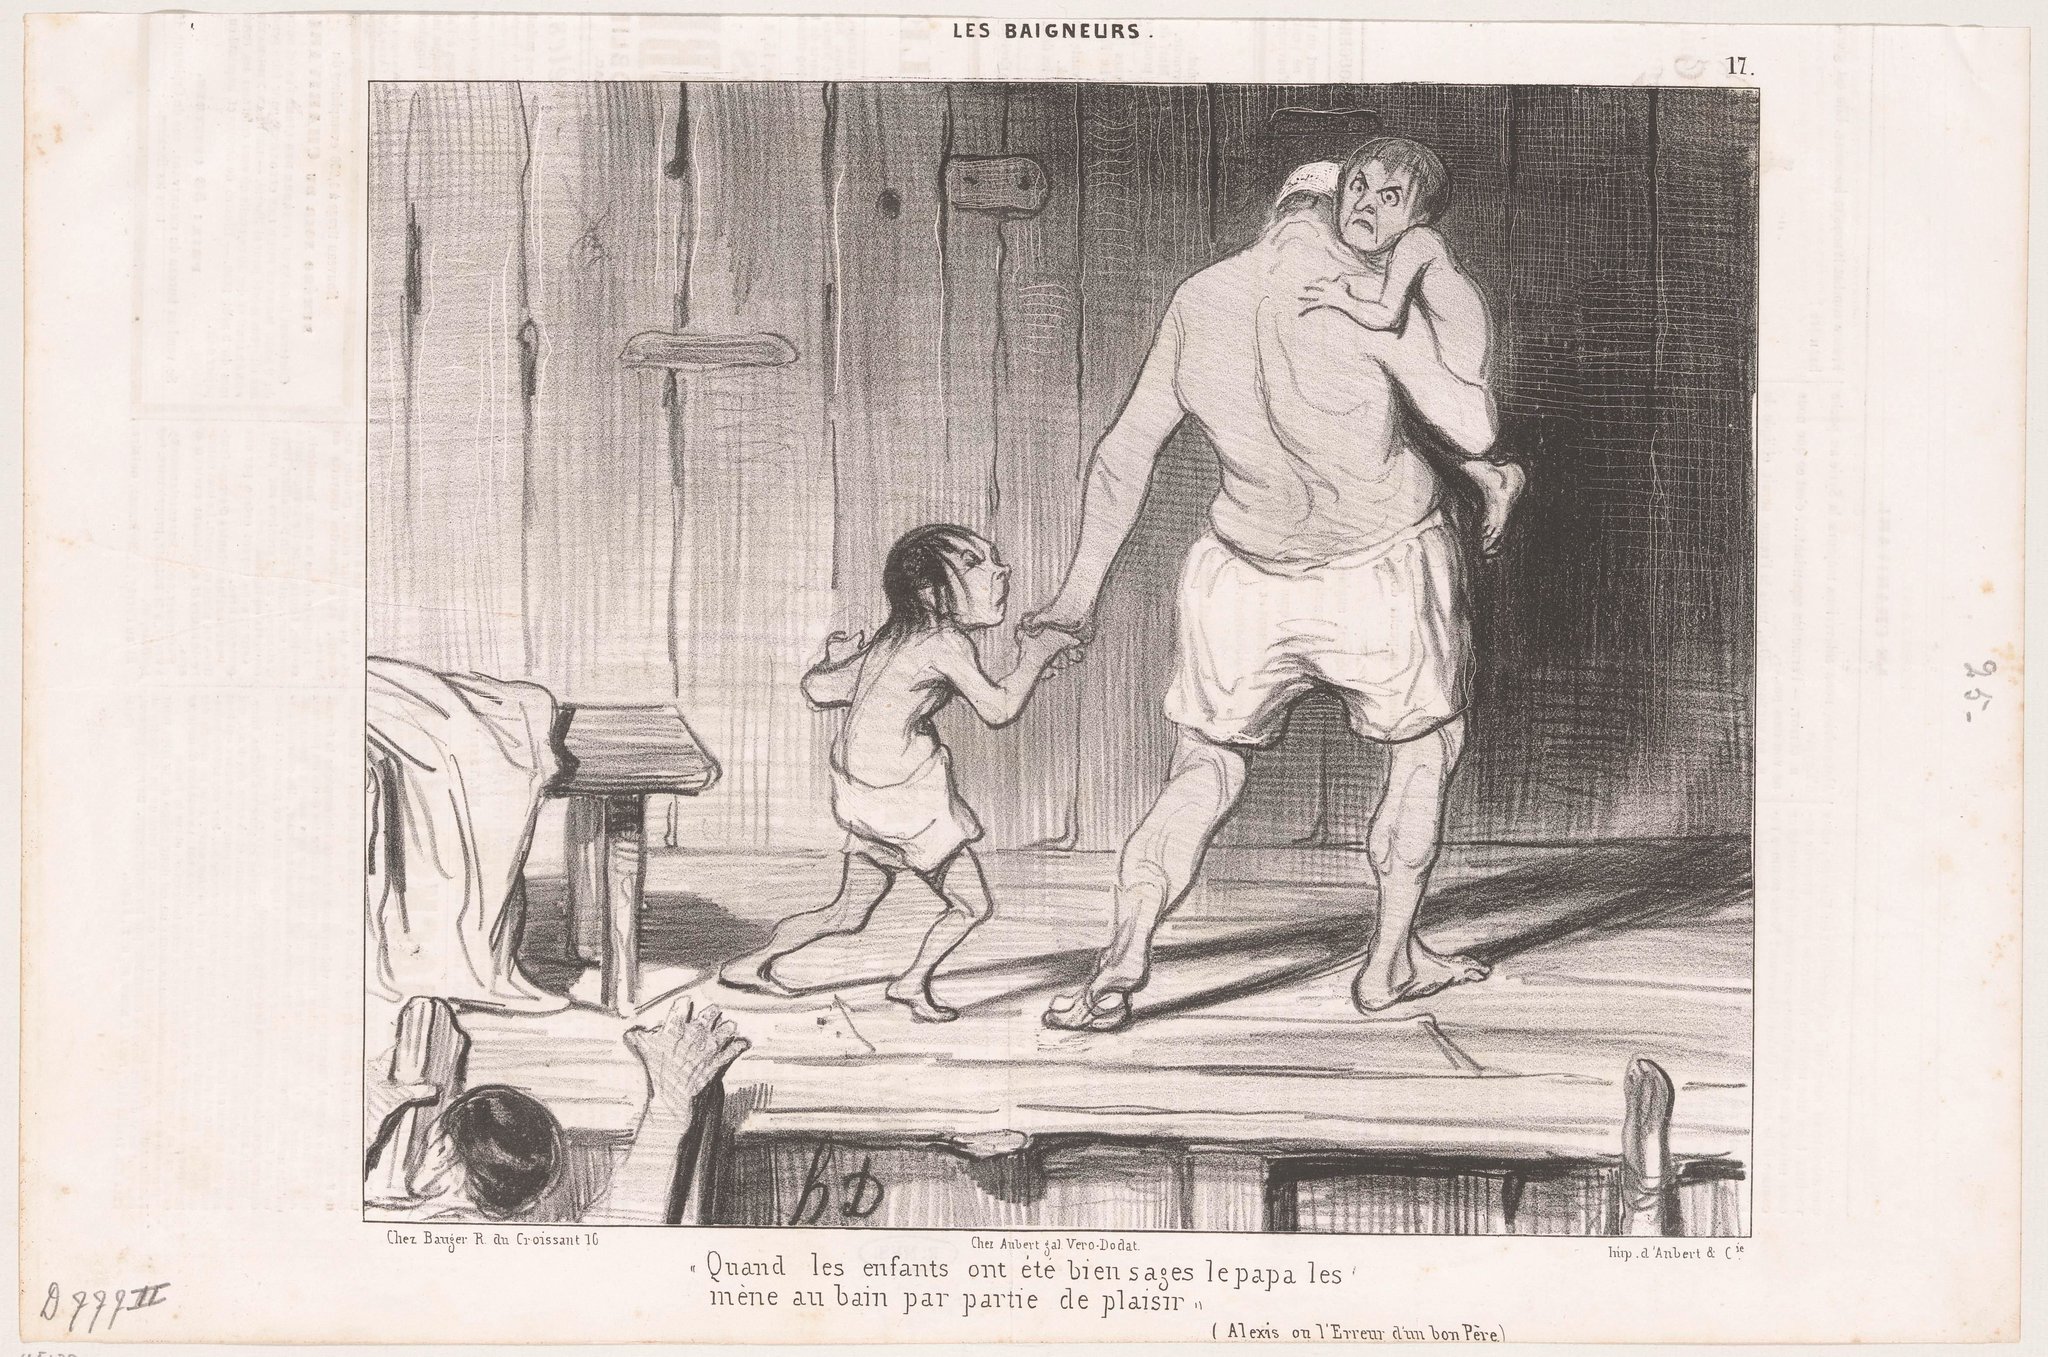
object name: cartoon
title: Badende mannen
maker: honoré daumier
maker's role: draughtsman, painter, print maker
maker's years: 1808-1879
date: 1840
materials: paper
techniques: letterpress printing, lithograph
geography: paris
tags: caricatures (human types), public baths, father and child(ren), man and child(ren) (family group)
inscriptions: collector's mark: Lugt 2228a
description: Prent mogelijk uit: Le Charivari, 6 september 1840.